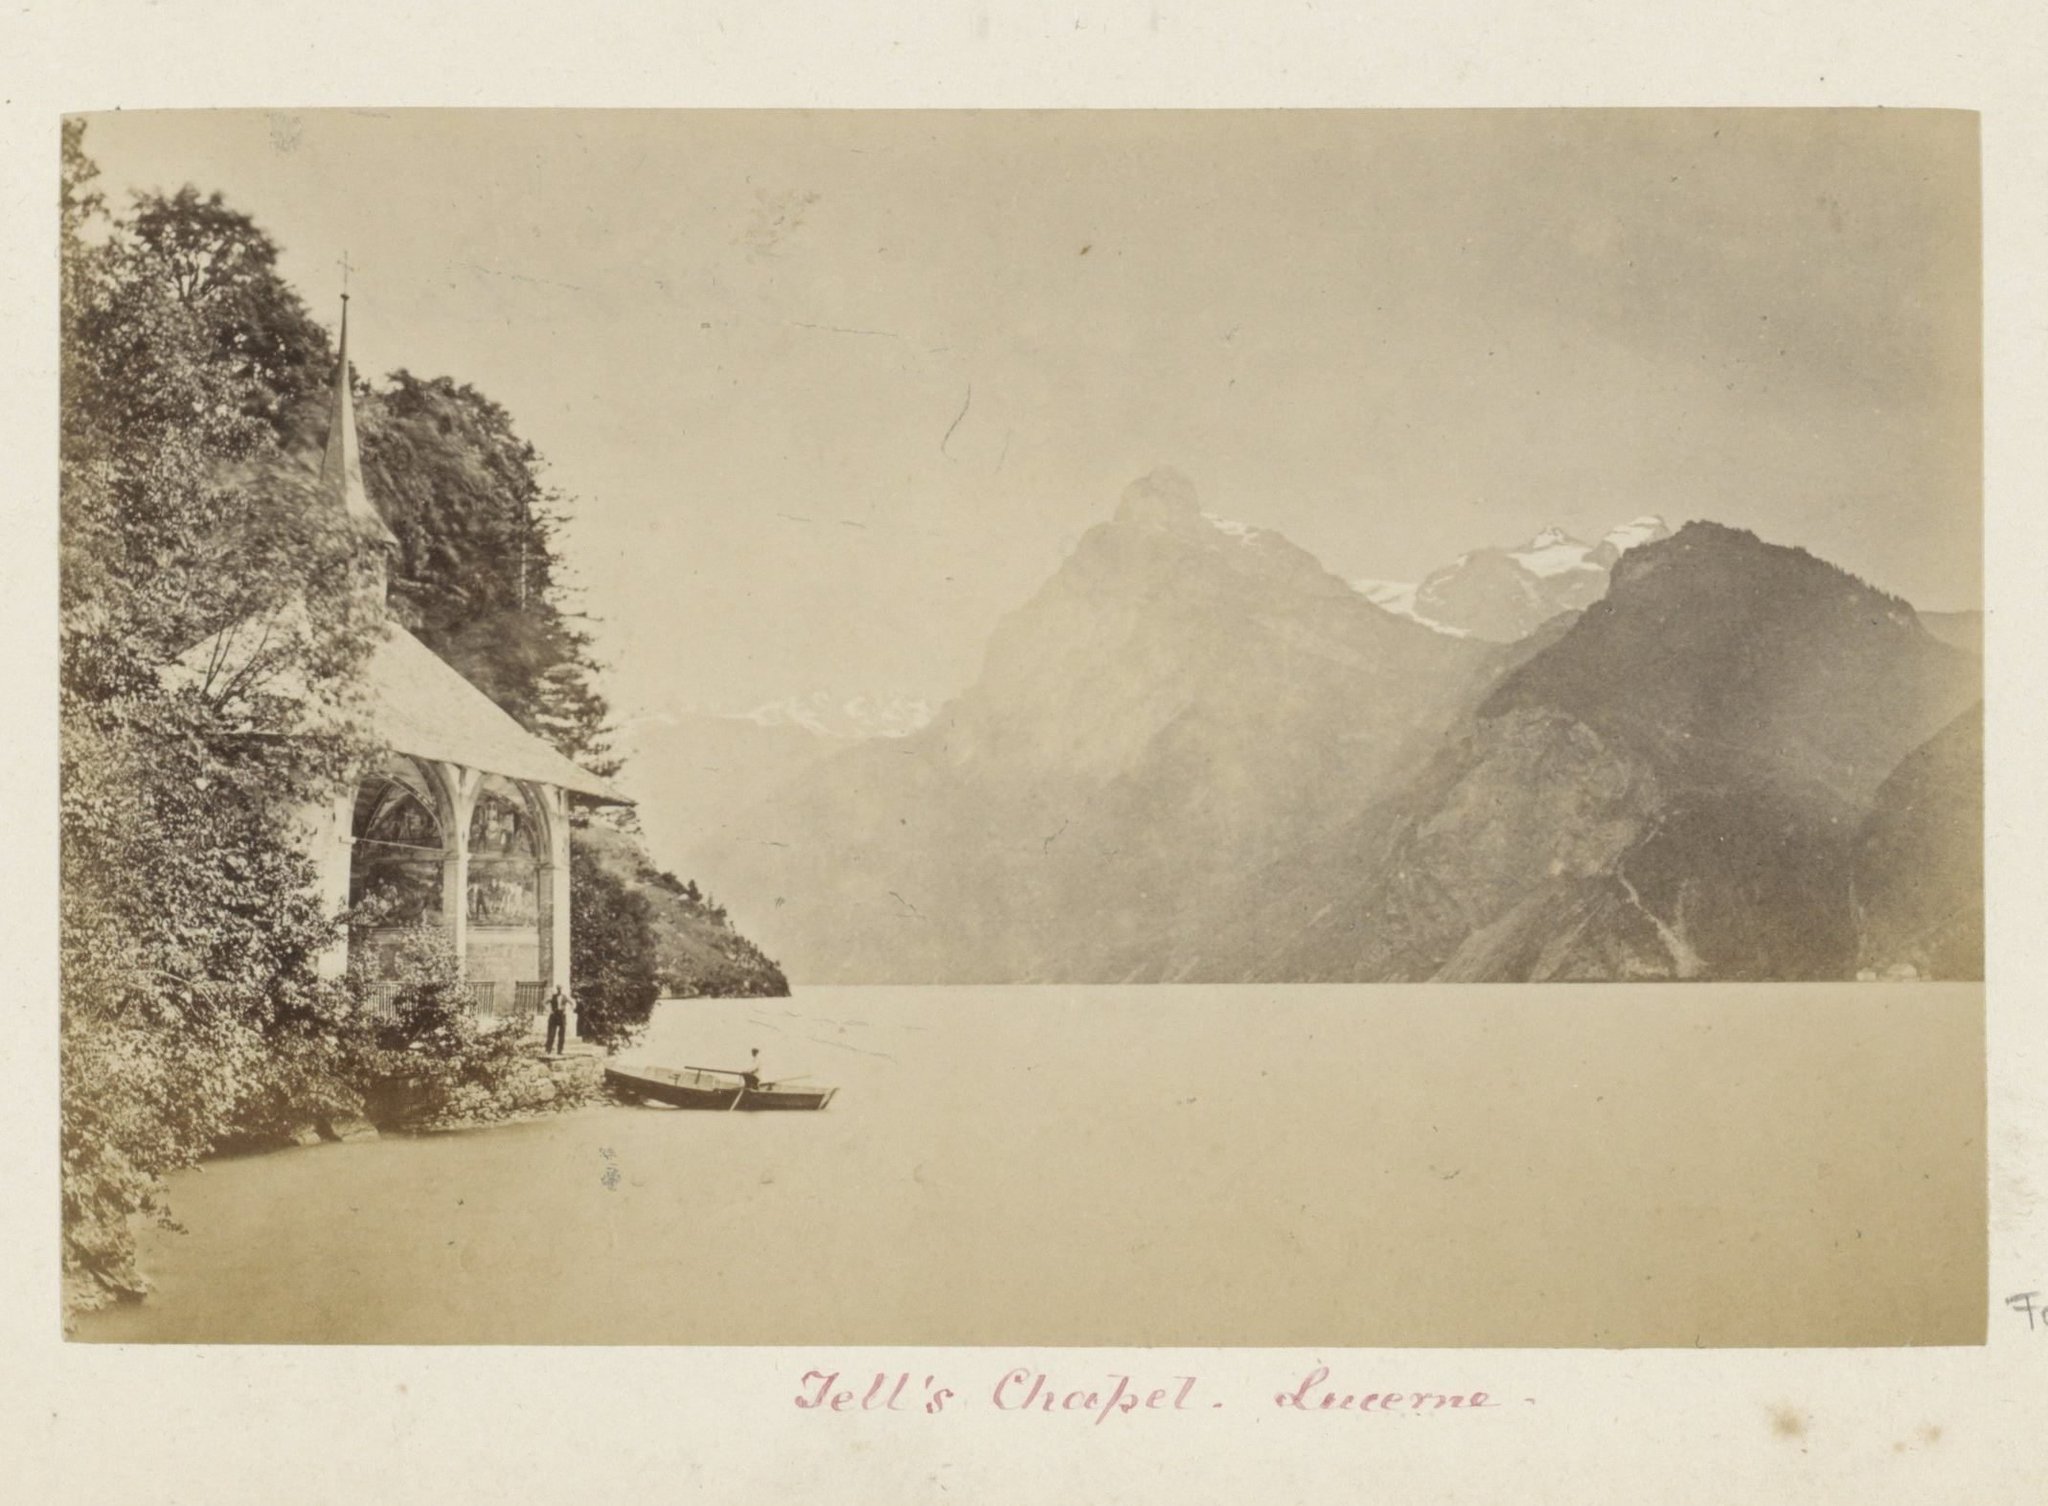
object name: photograph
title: Tell's Chapel. Lucerne.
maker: Anonymous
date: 1860-1890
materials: paper, photographic support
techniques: albumen print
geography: vierwoudstrekenmeer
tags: lake, mountain-range, snow peaks, church (exterior) - qq - small church, chapel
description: Onderdeel van Reisalbum met foto's van Zwitserland, Oostenrijk, Italië en Duitsland.